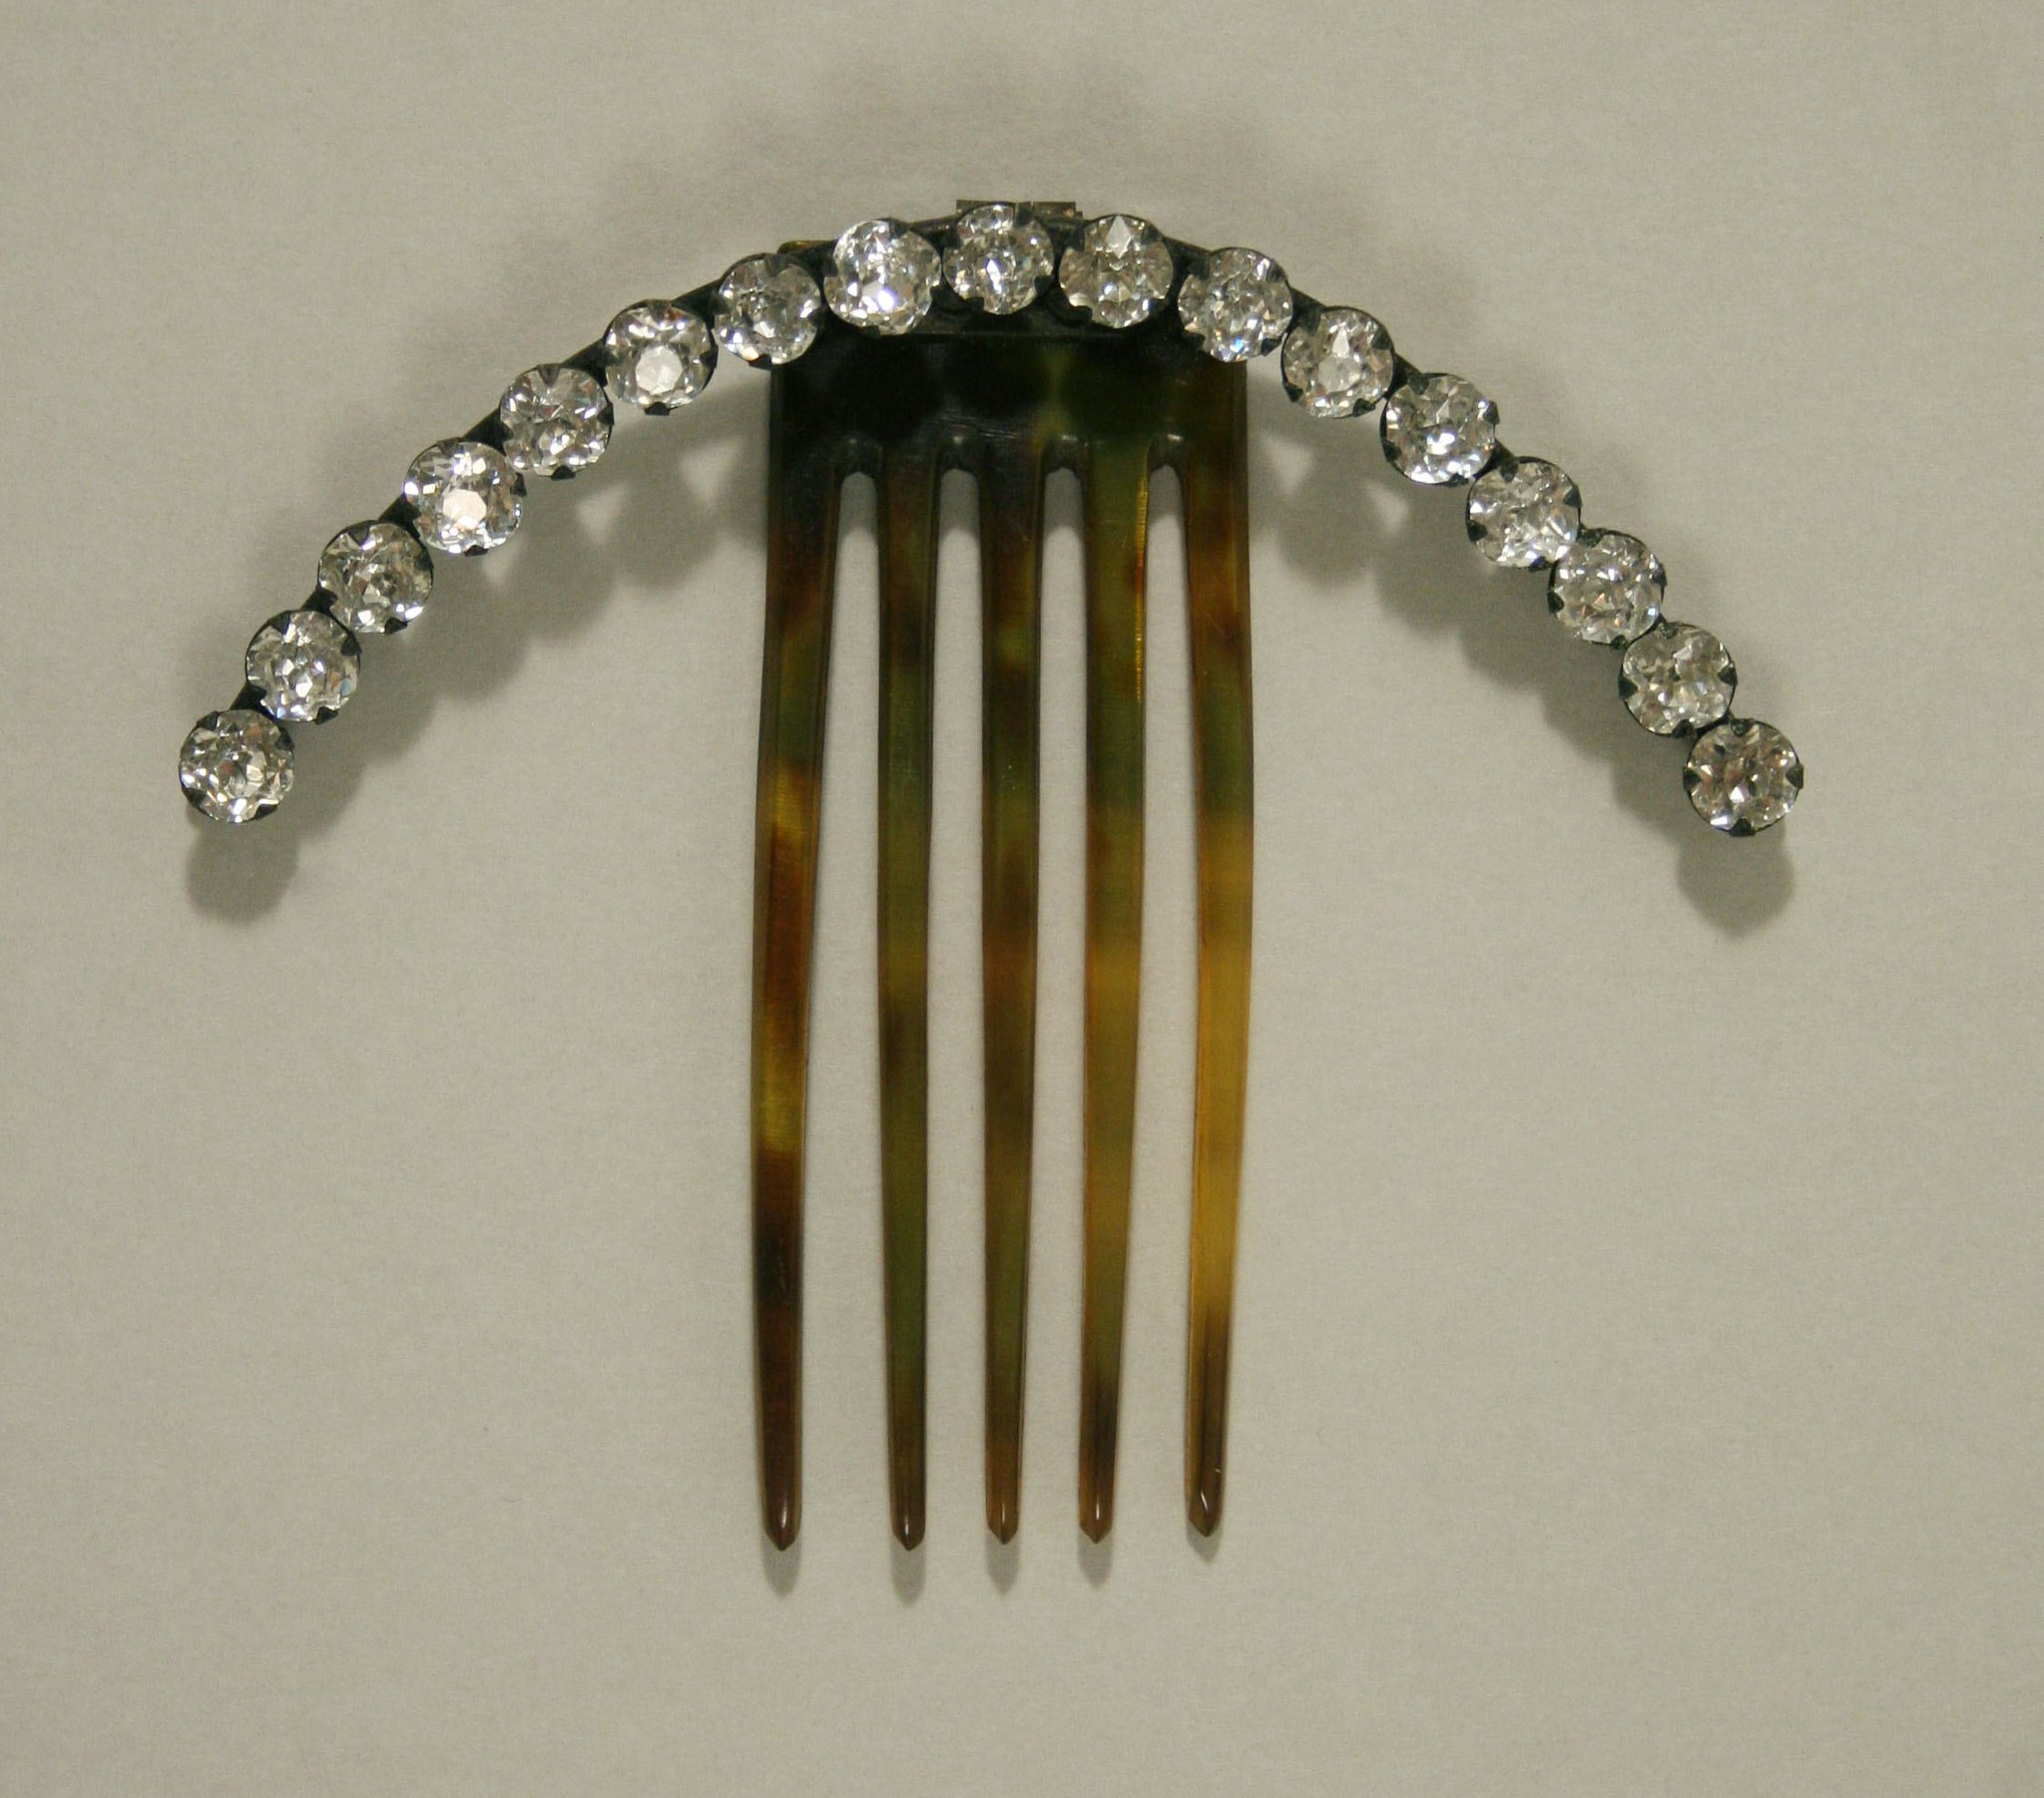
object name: comb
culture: american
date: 1880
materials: metal, plastic